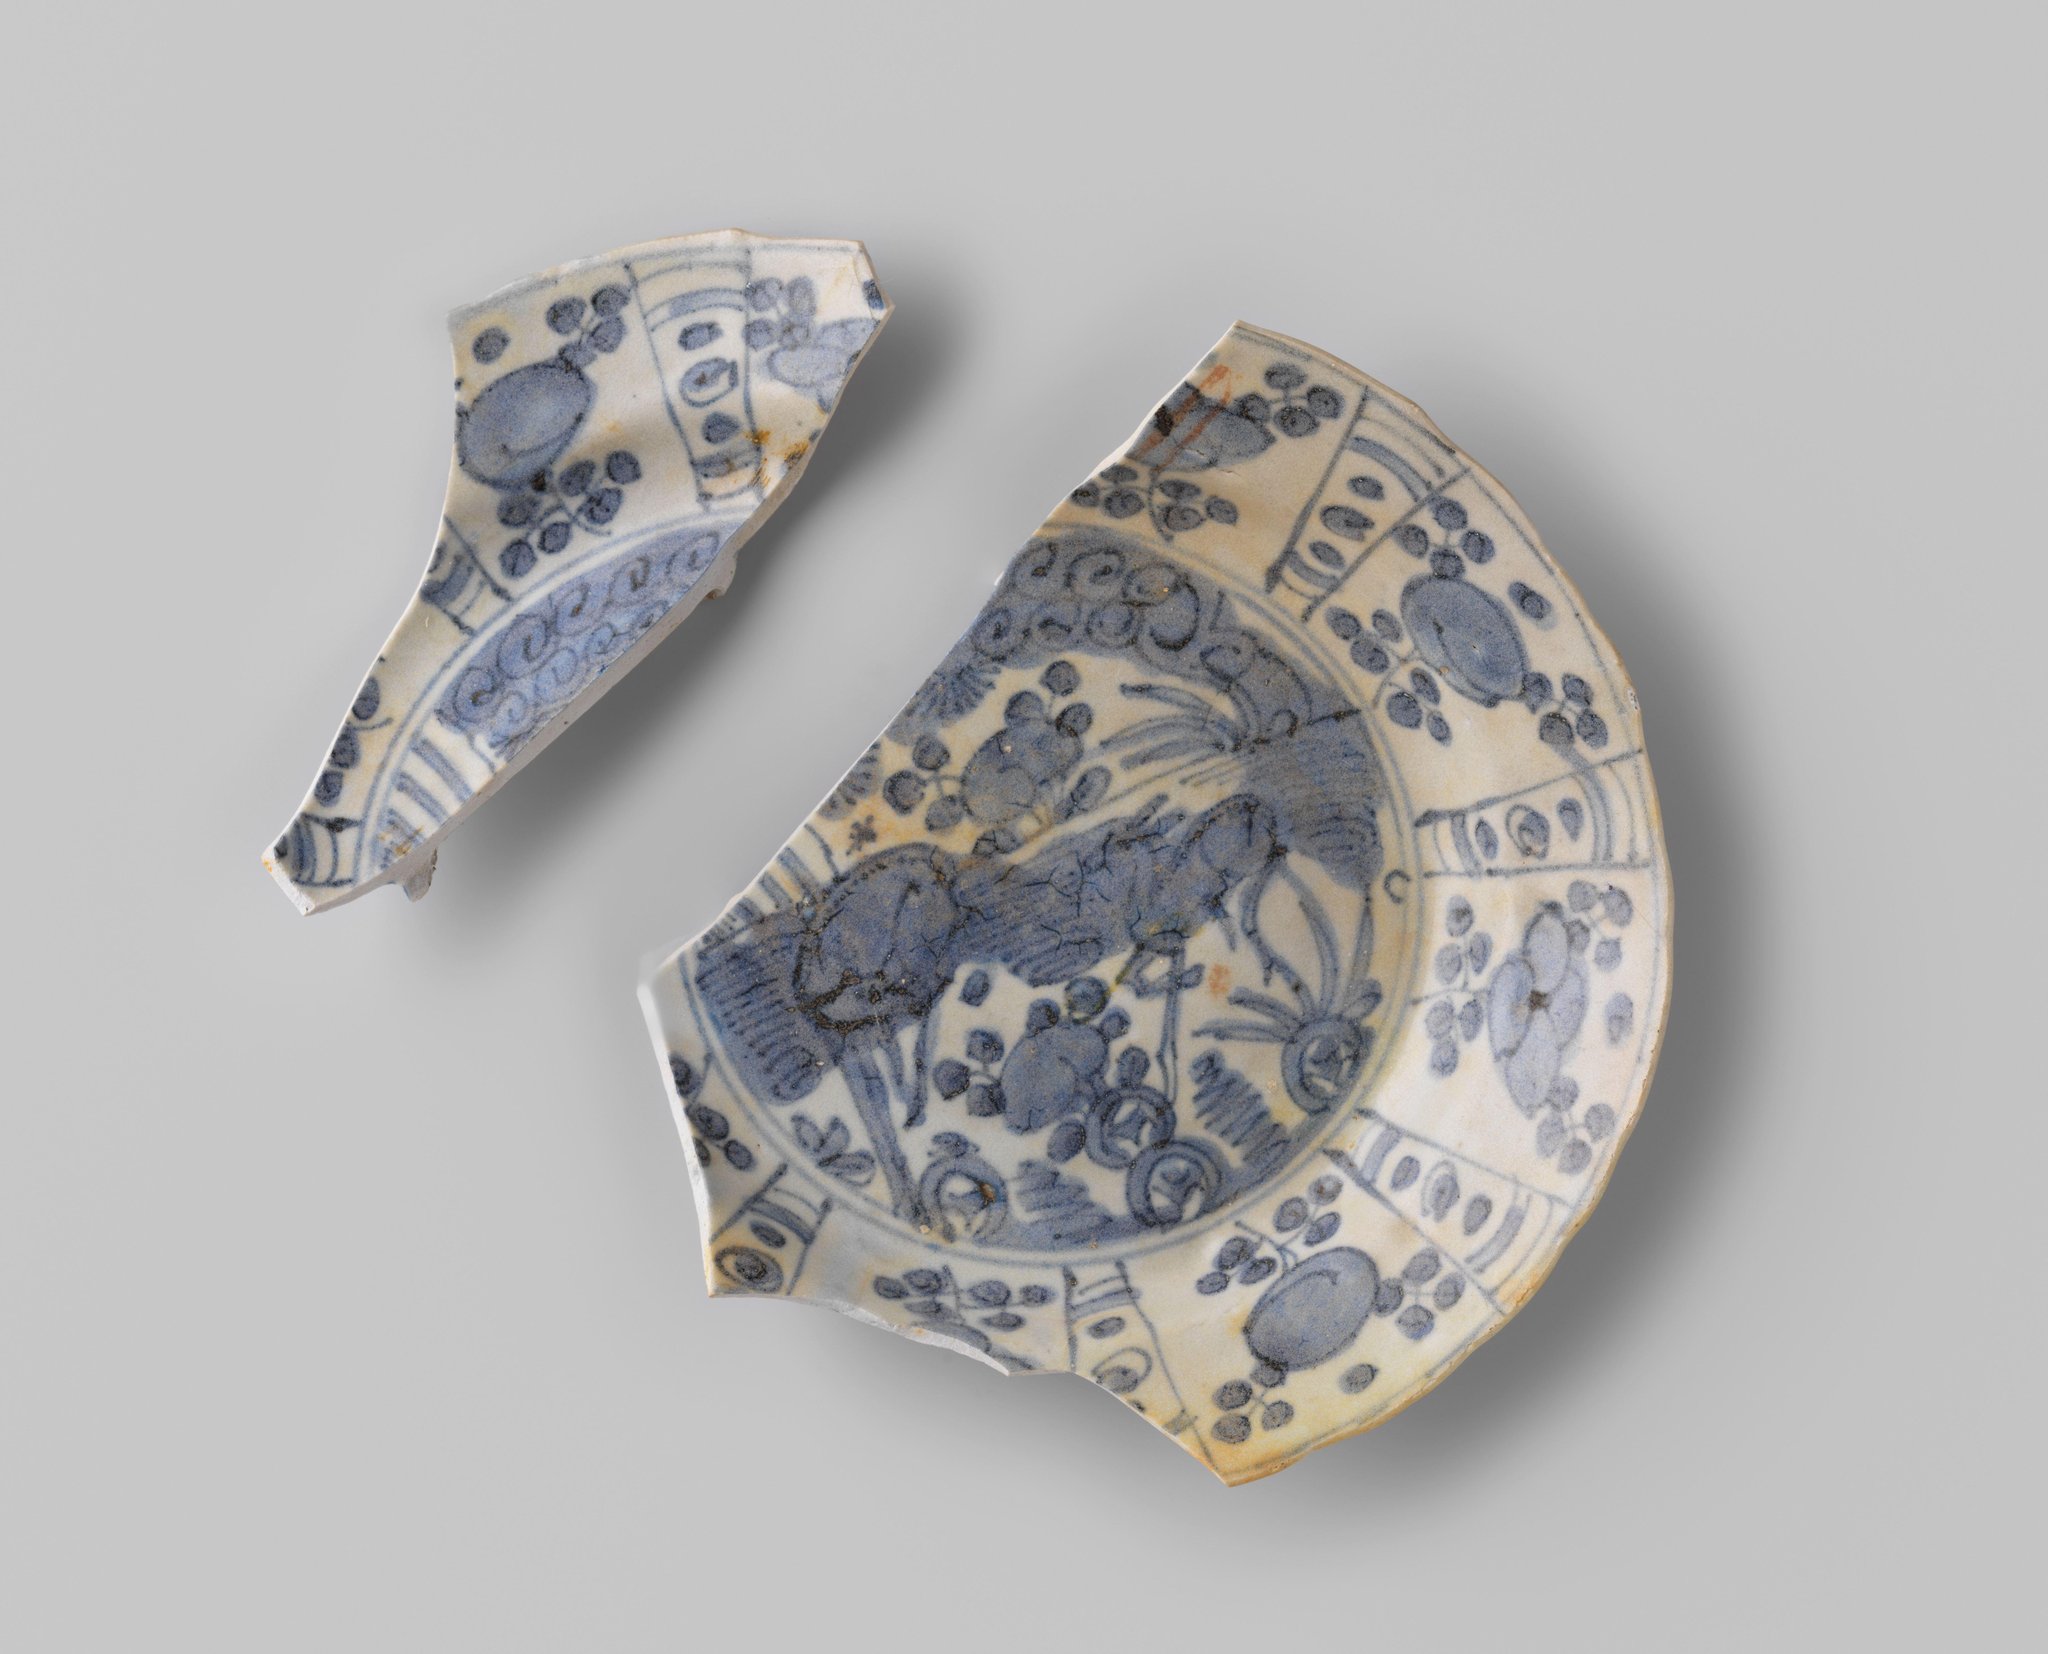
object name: plate dish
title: Fragment bord uit V.O.C.-schip de 'Witte Leeuw'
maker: Anonymous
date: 1613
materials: bone china, porcelain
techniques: painted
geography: jingdezhen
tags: verenigde oostindische compagnie, sint-helena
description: A plate with a flattened rim. A star-shaped medallion with 4 rui heads and various diaper patterns. These plates all have a central decoration of symbols; the decoration on cavetto and rim are also similar. Another typical feature of these plates is the pattern resembling the imprint of woven cloth in the centre, under the glaze. A central decoration of an insect on a rock. Panels decorated with peaches and symbols.